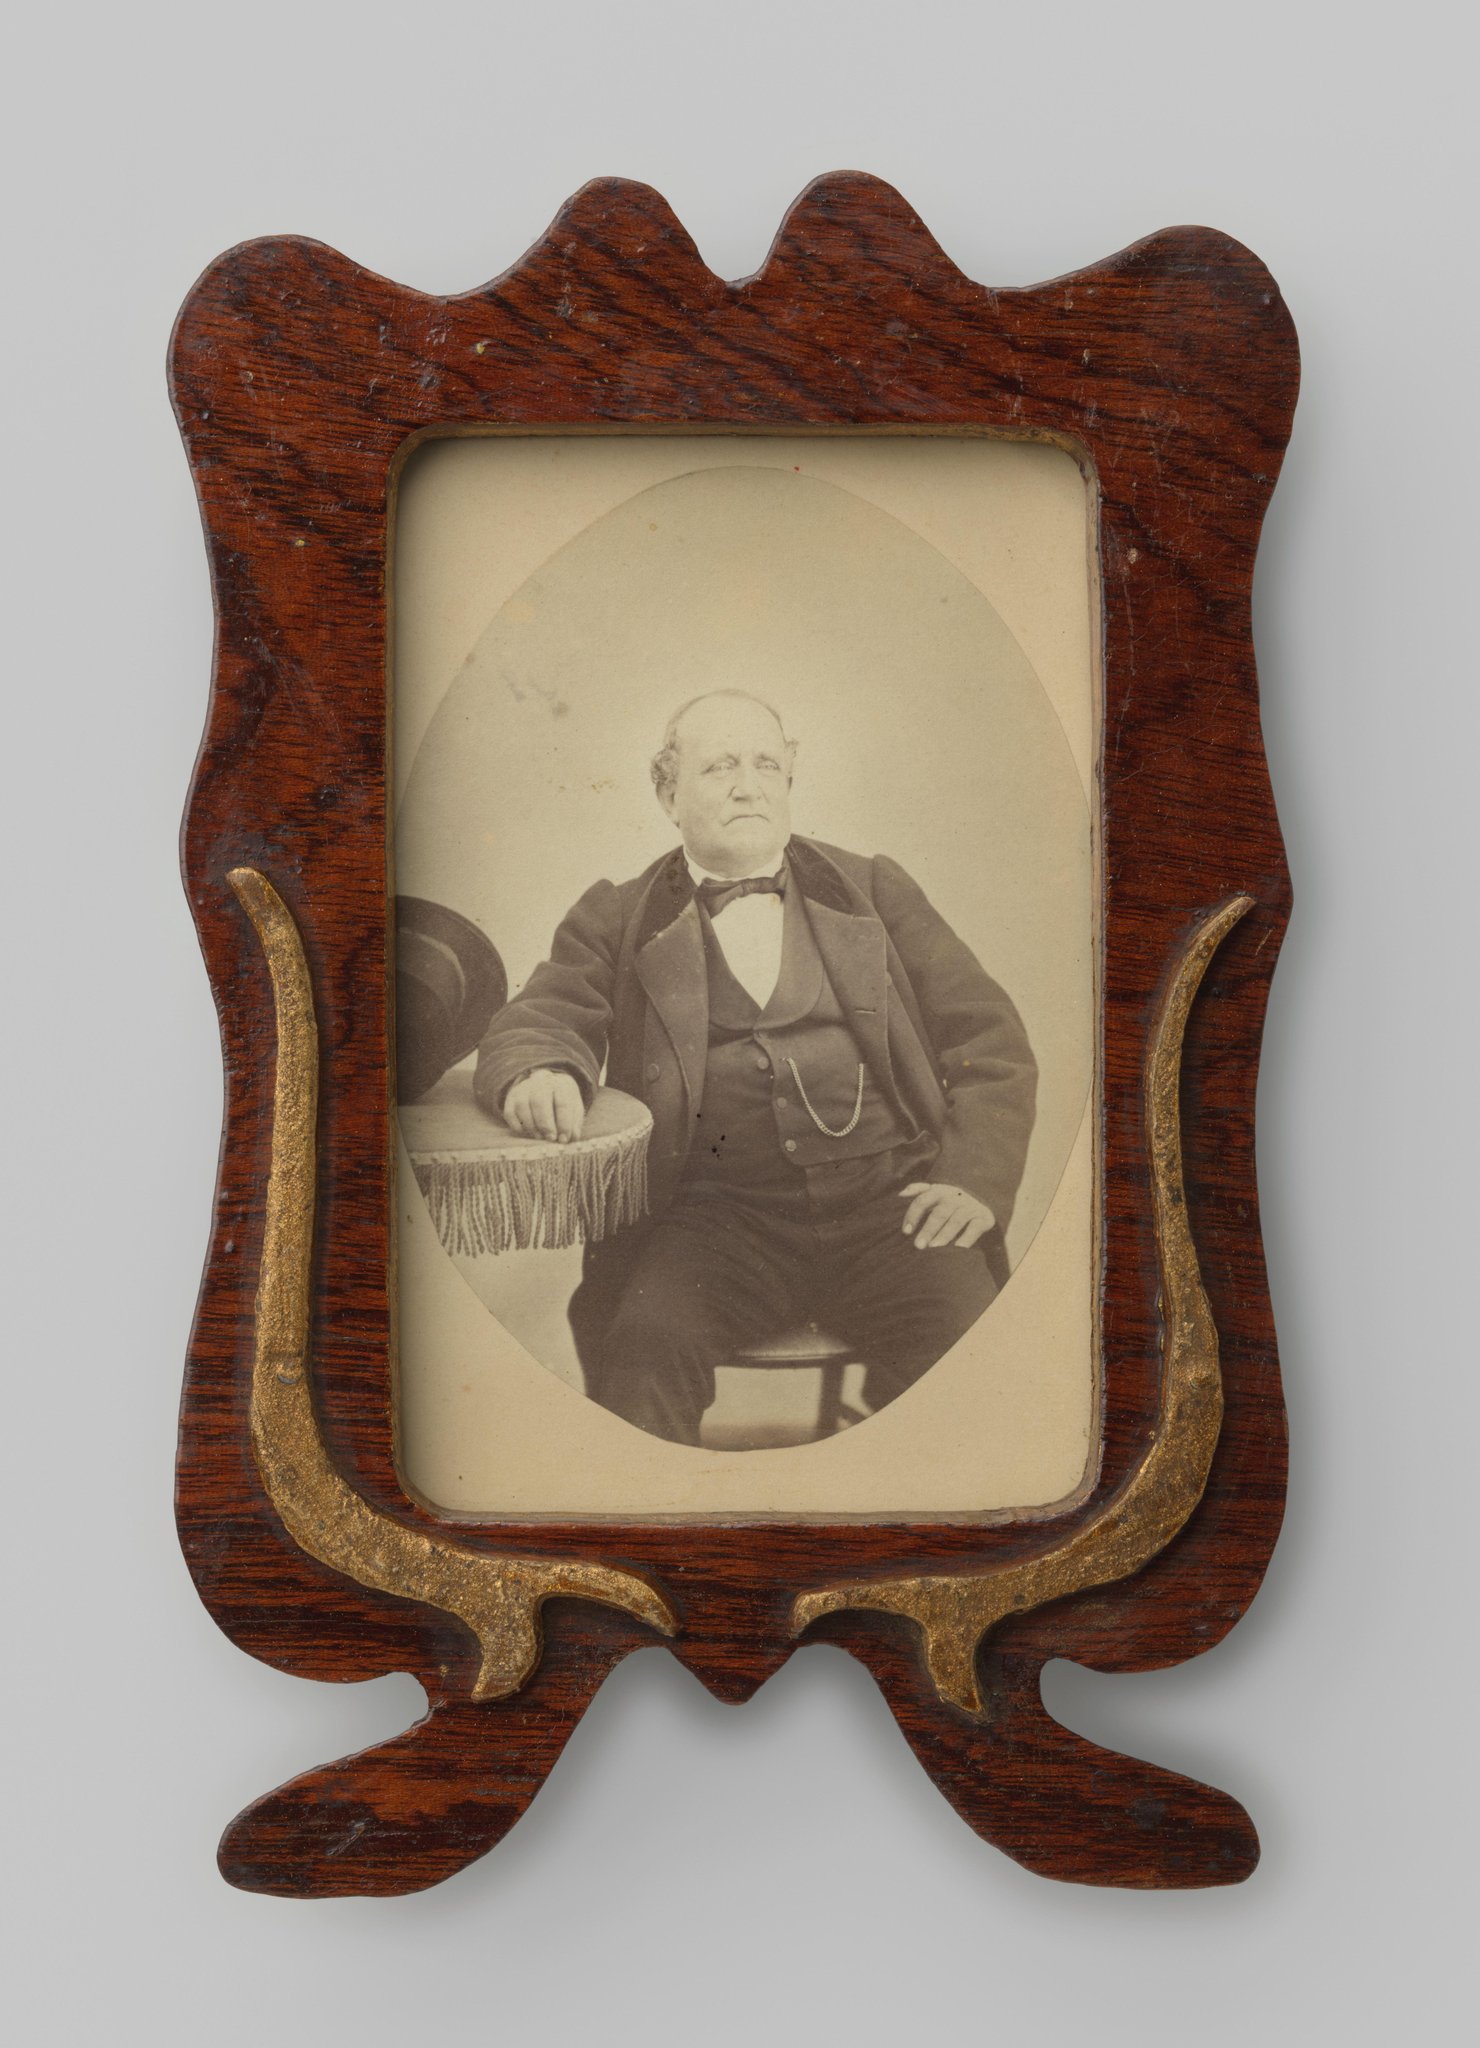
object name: frame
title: Portret van een onbekende zittende man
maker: Anonymous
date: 1880-1900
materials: cardboard, glass, metal, paper, wood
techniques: albumen print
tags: sitting figure, adult man, anonymous historical person portrayed